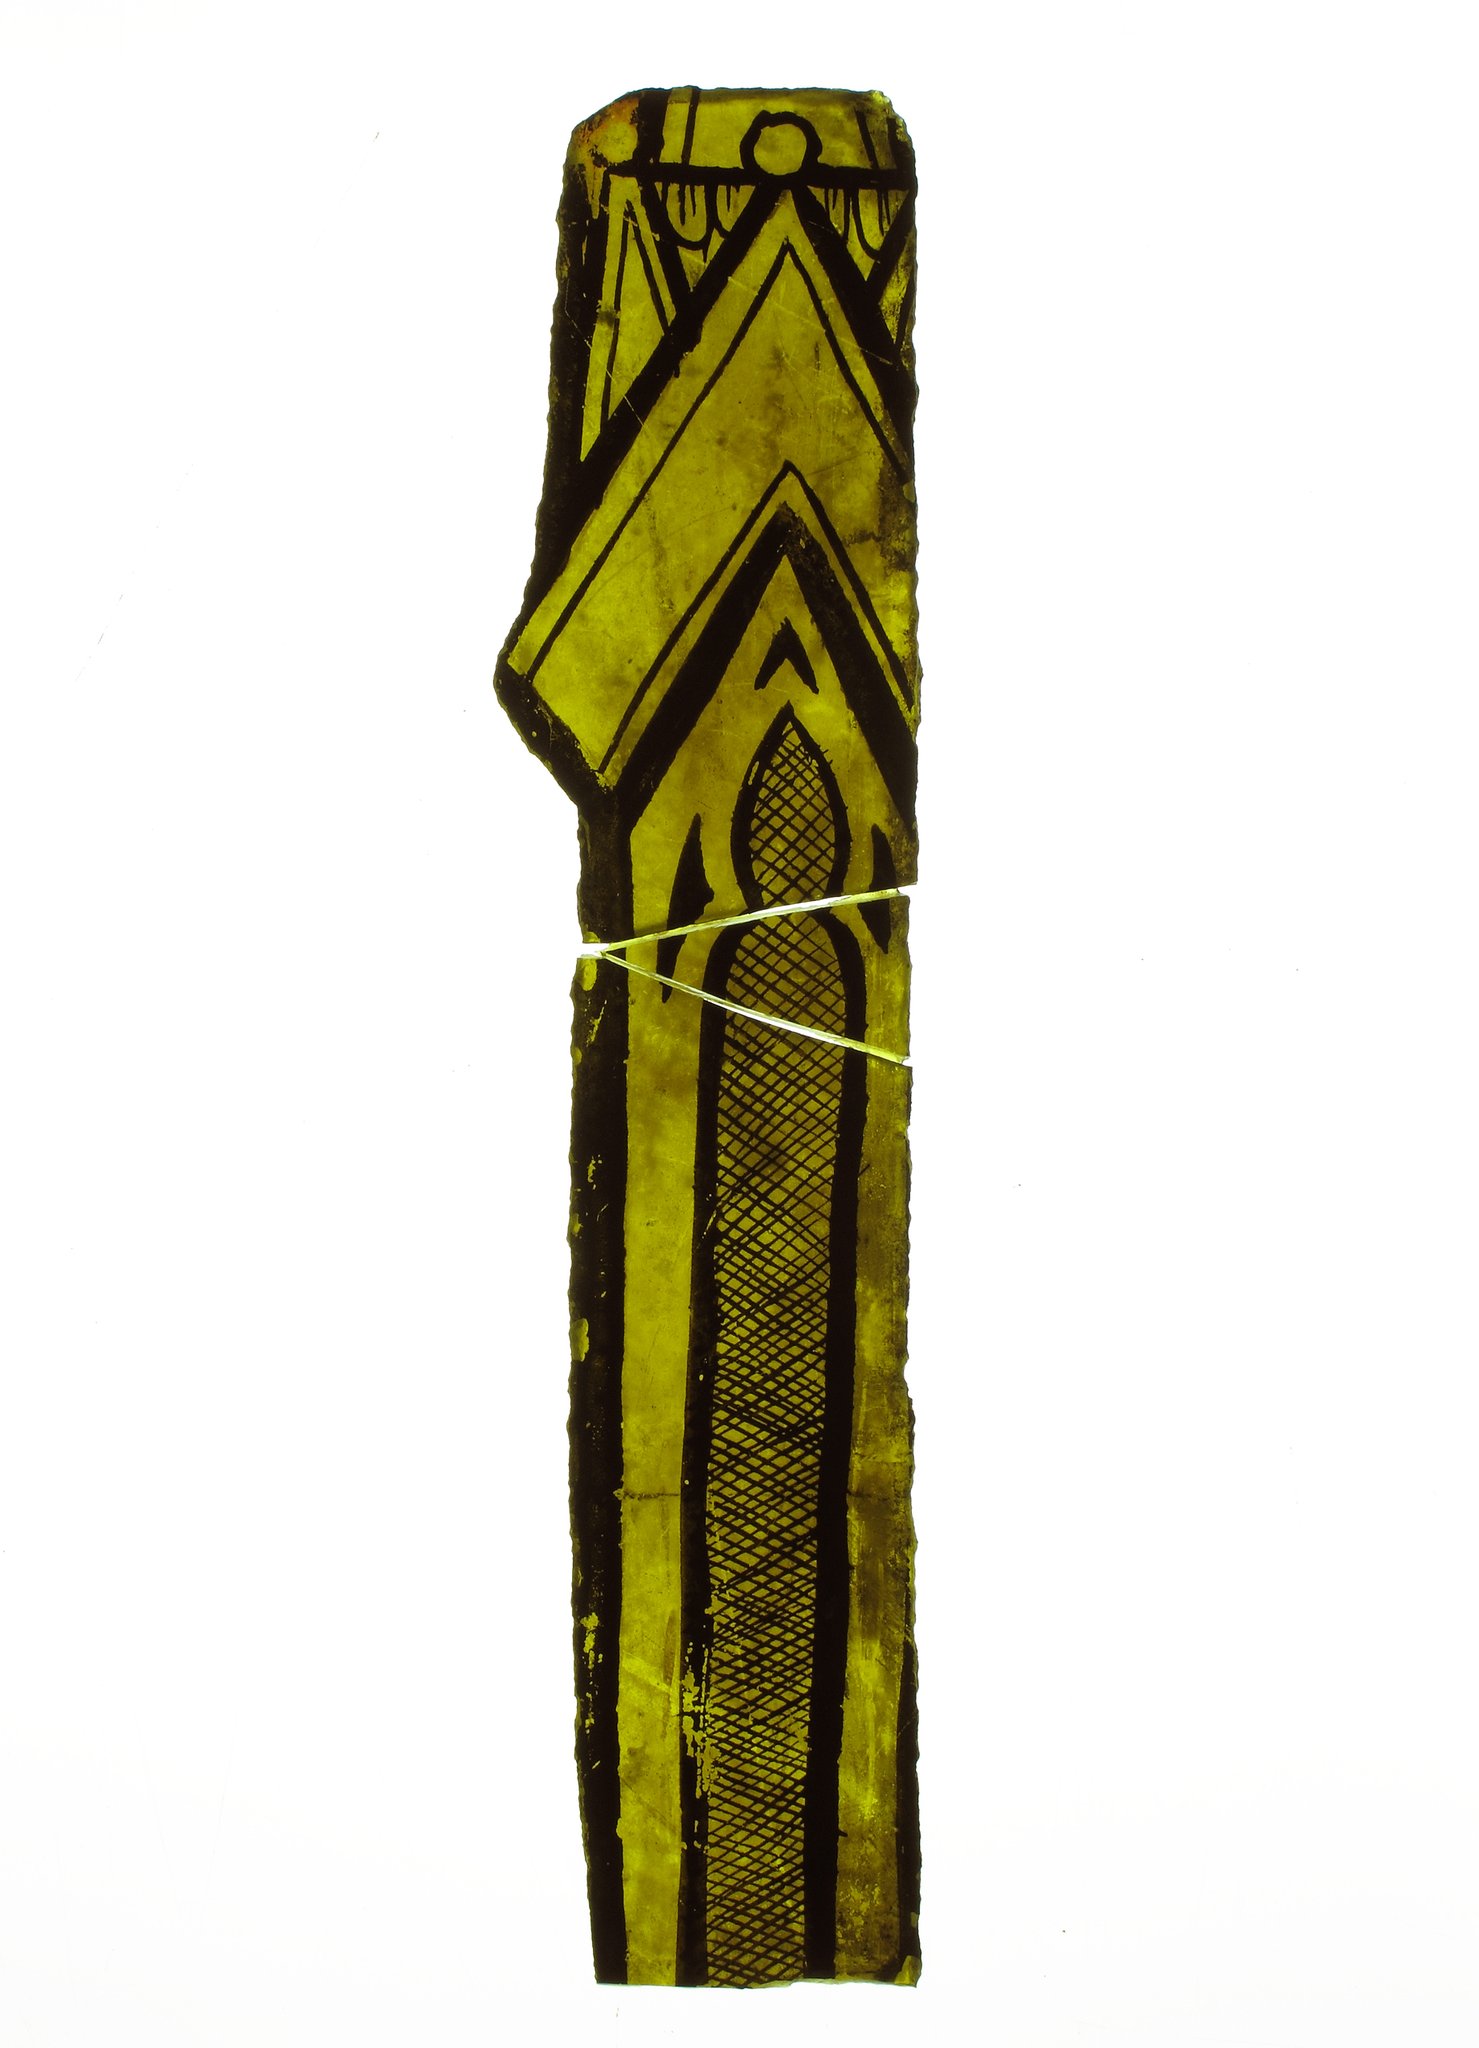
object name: fragment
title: Glass Fragment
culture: european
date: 1301-1500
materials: glass, metal